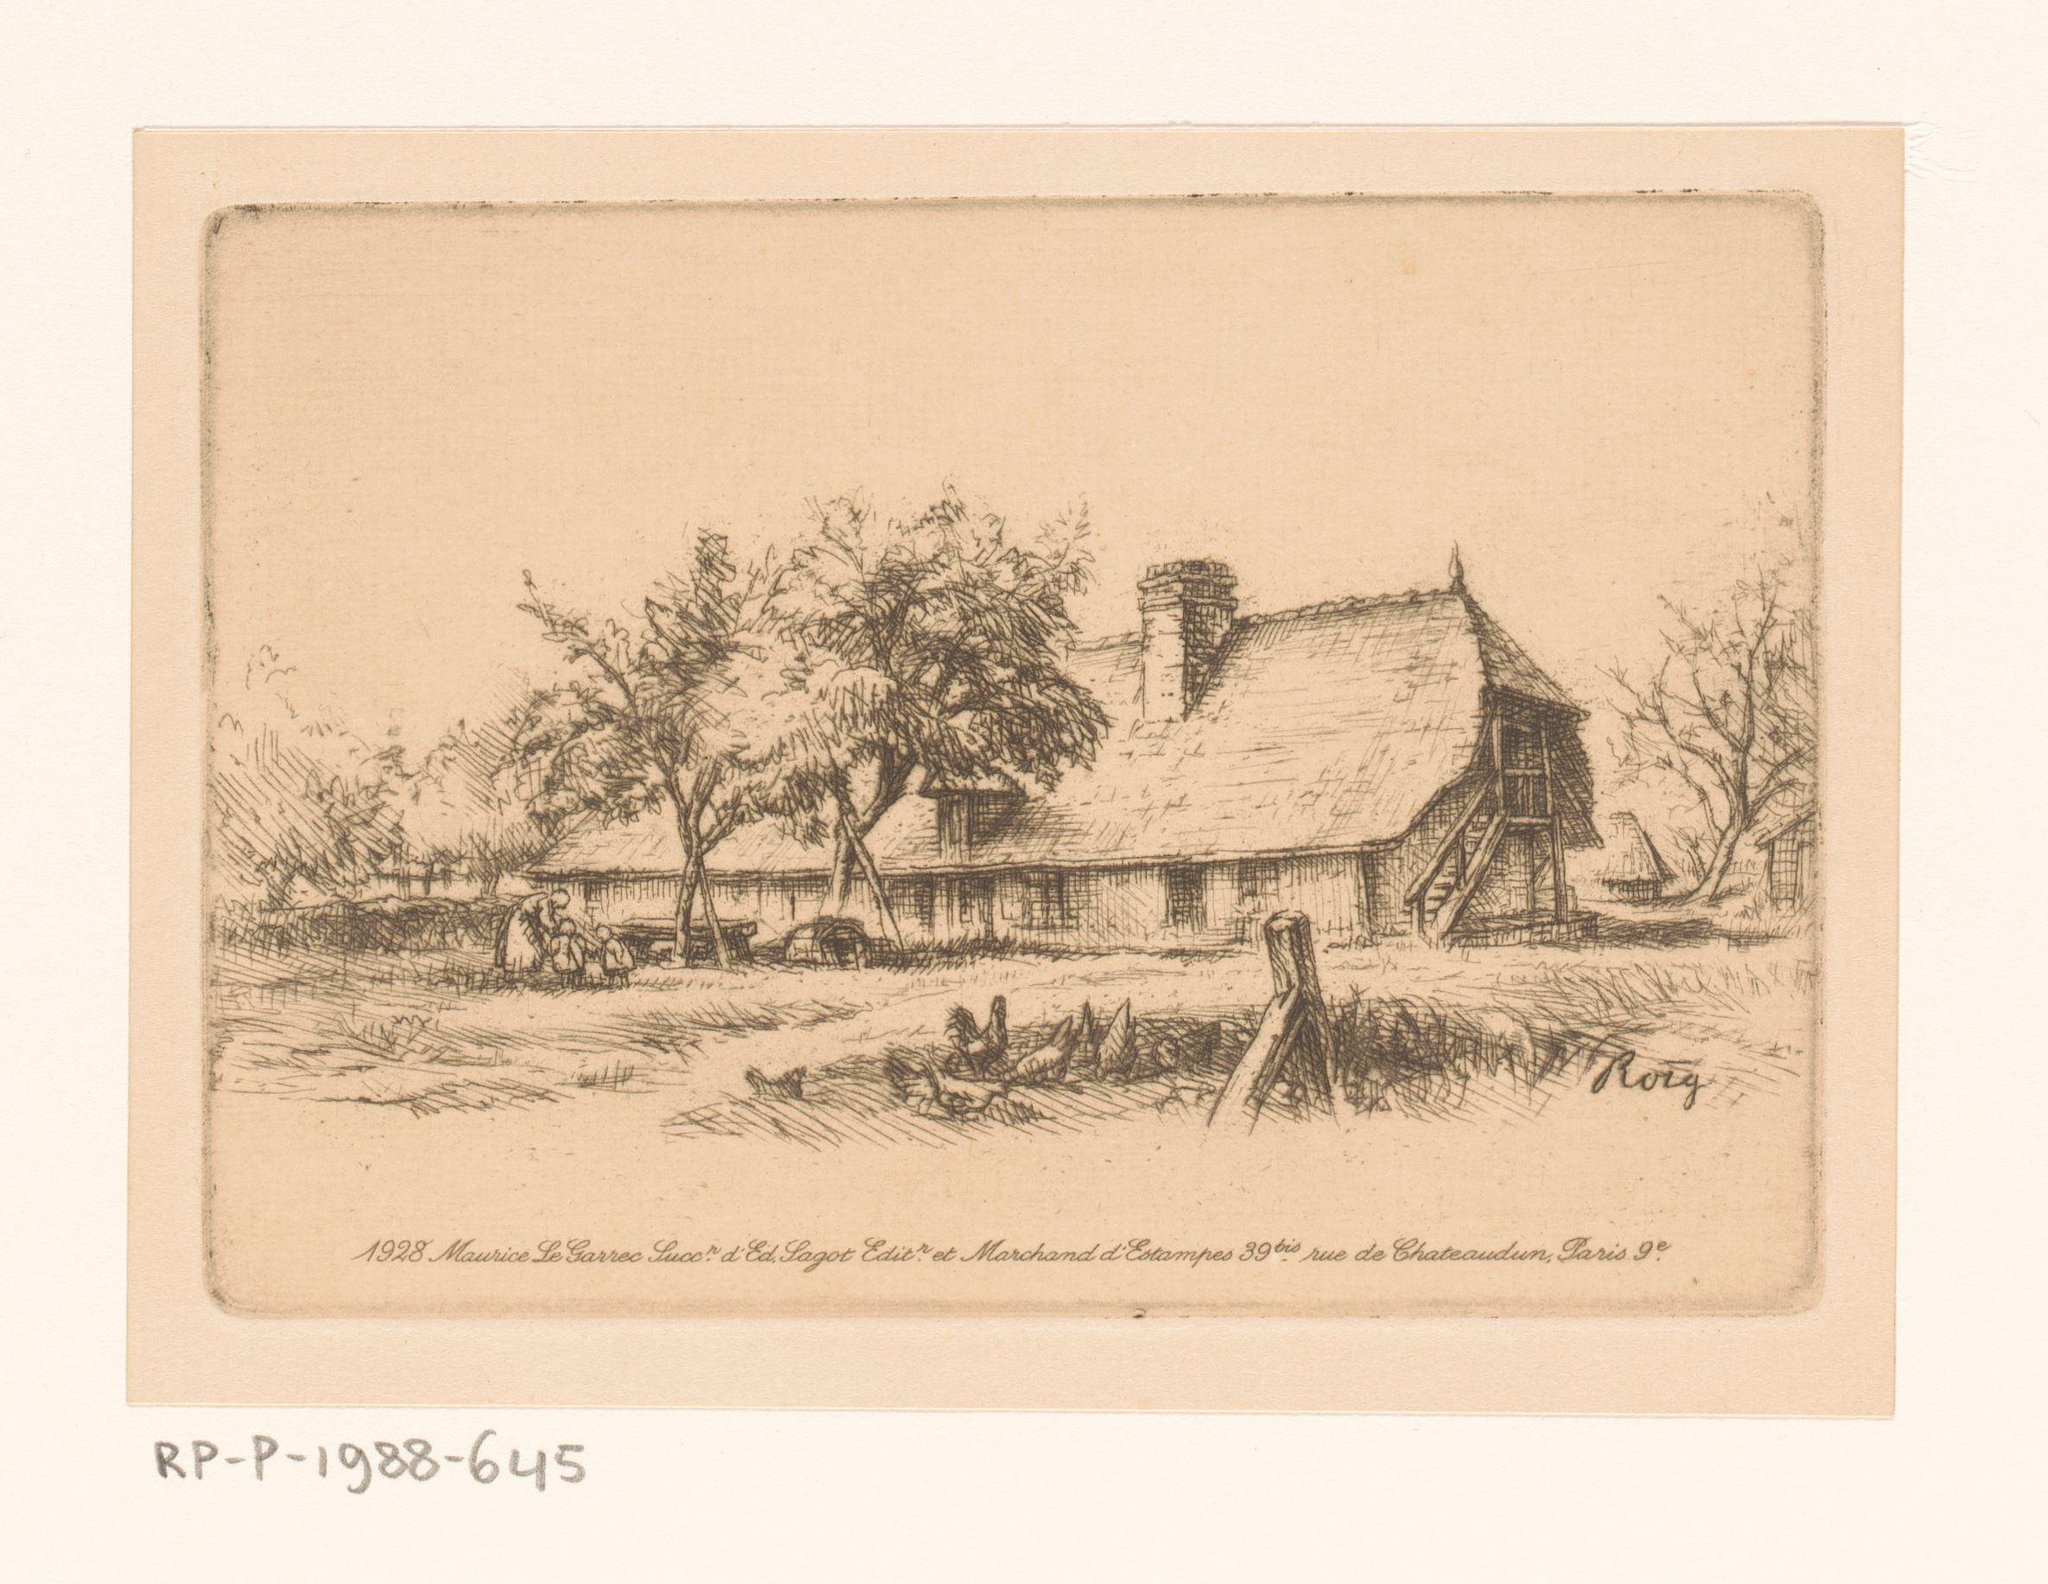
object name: print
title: Boerderij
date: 1928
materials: paper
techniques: etching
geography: paris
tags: farm or solitary house in landscape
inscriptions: collector's mark: Lugt 2228